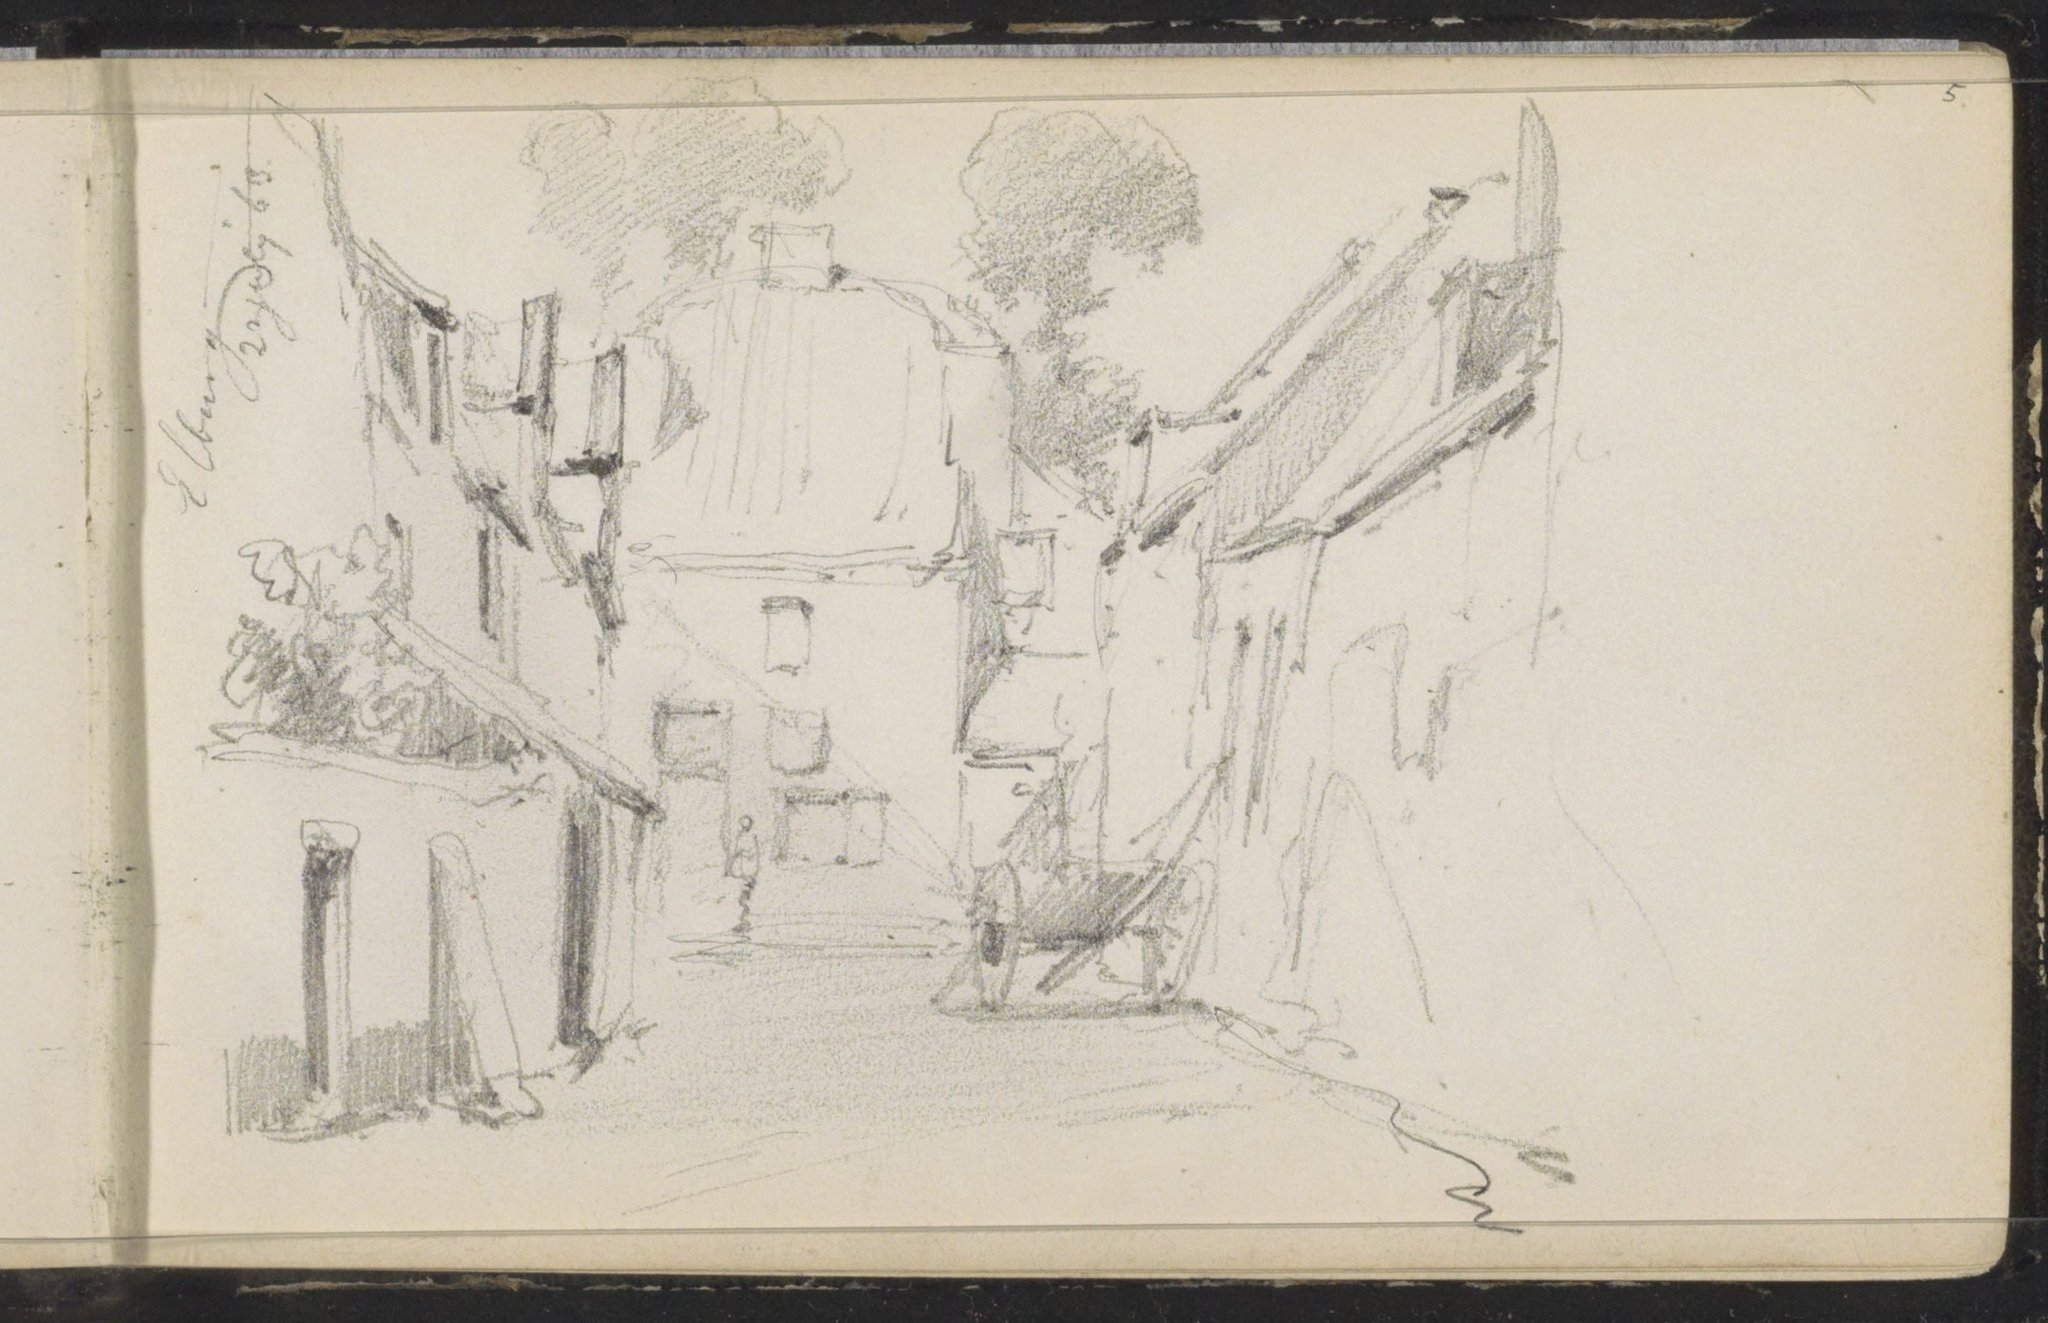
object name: sketchbook leaf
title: Gezicht op een straat in Elburg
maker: cornelis springer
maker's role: draughtsman, painter, print maker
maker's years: 1817-1891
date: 1863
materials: paper, pencil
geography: elburg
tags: hand-cart, street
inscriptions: annotation: ‘Elburg’, date: ‘22 july 63’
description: Gezicht op een straat in Elburg. Op straat staat een kar. Blad 5 uit een schetsboek met 55 bladen vervaardigd op de Veluwe en in Noord-Duitsland.